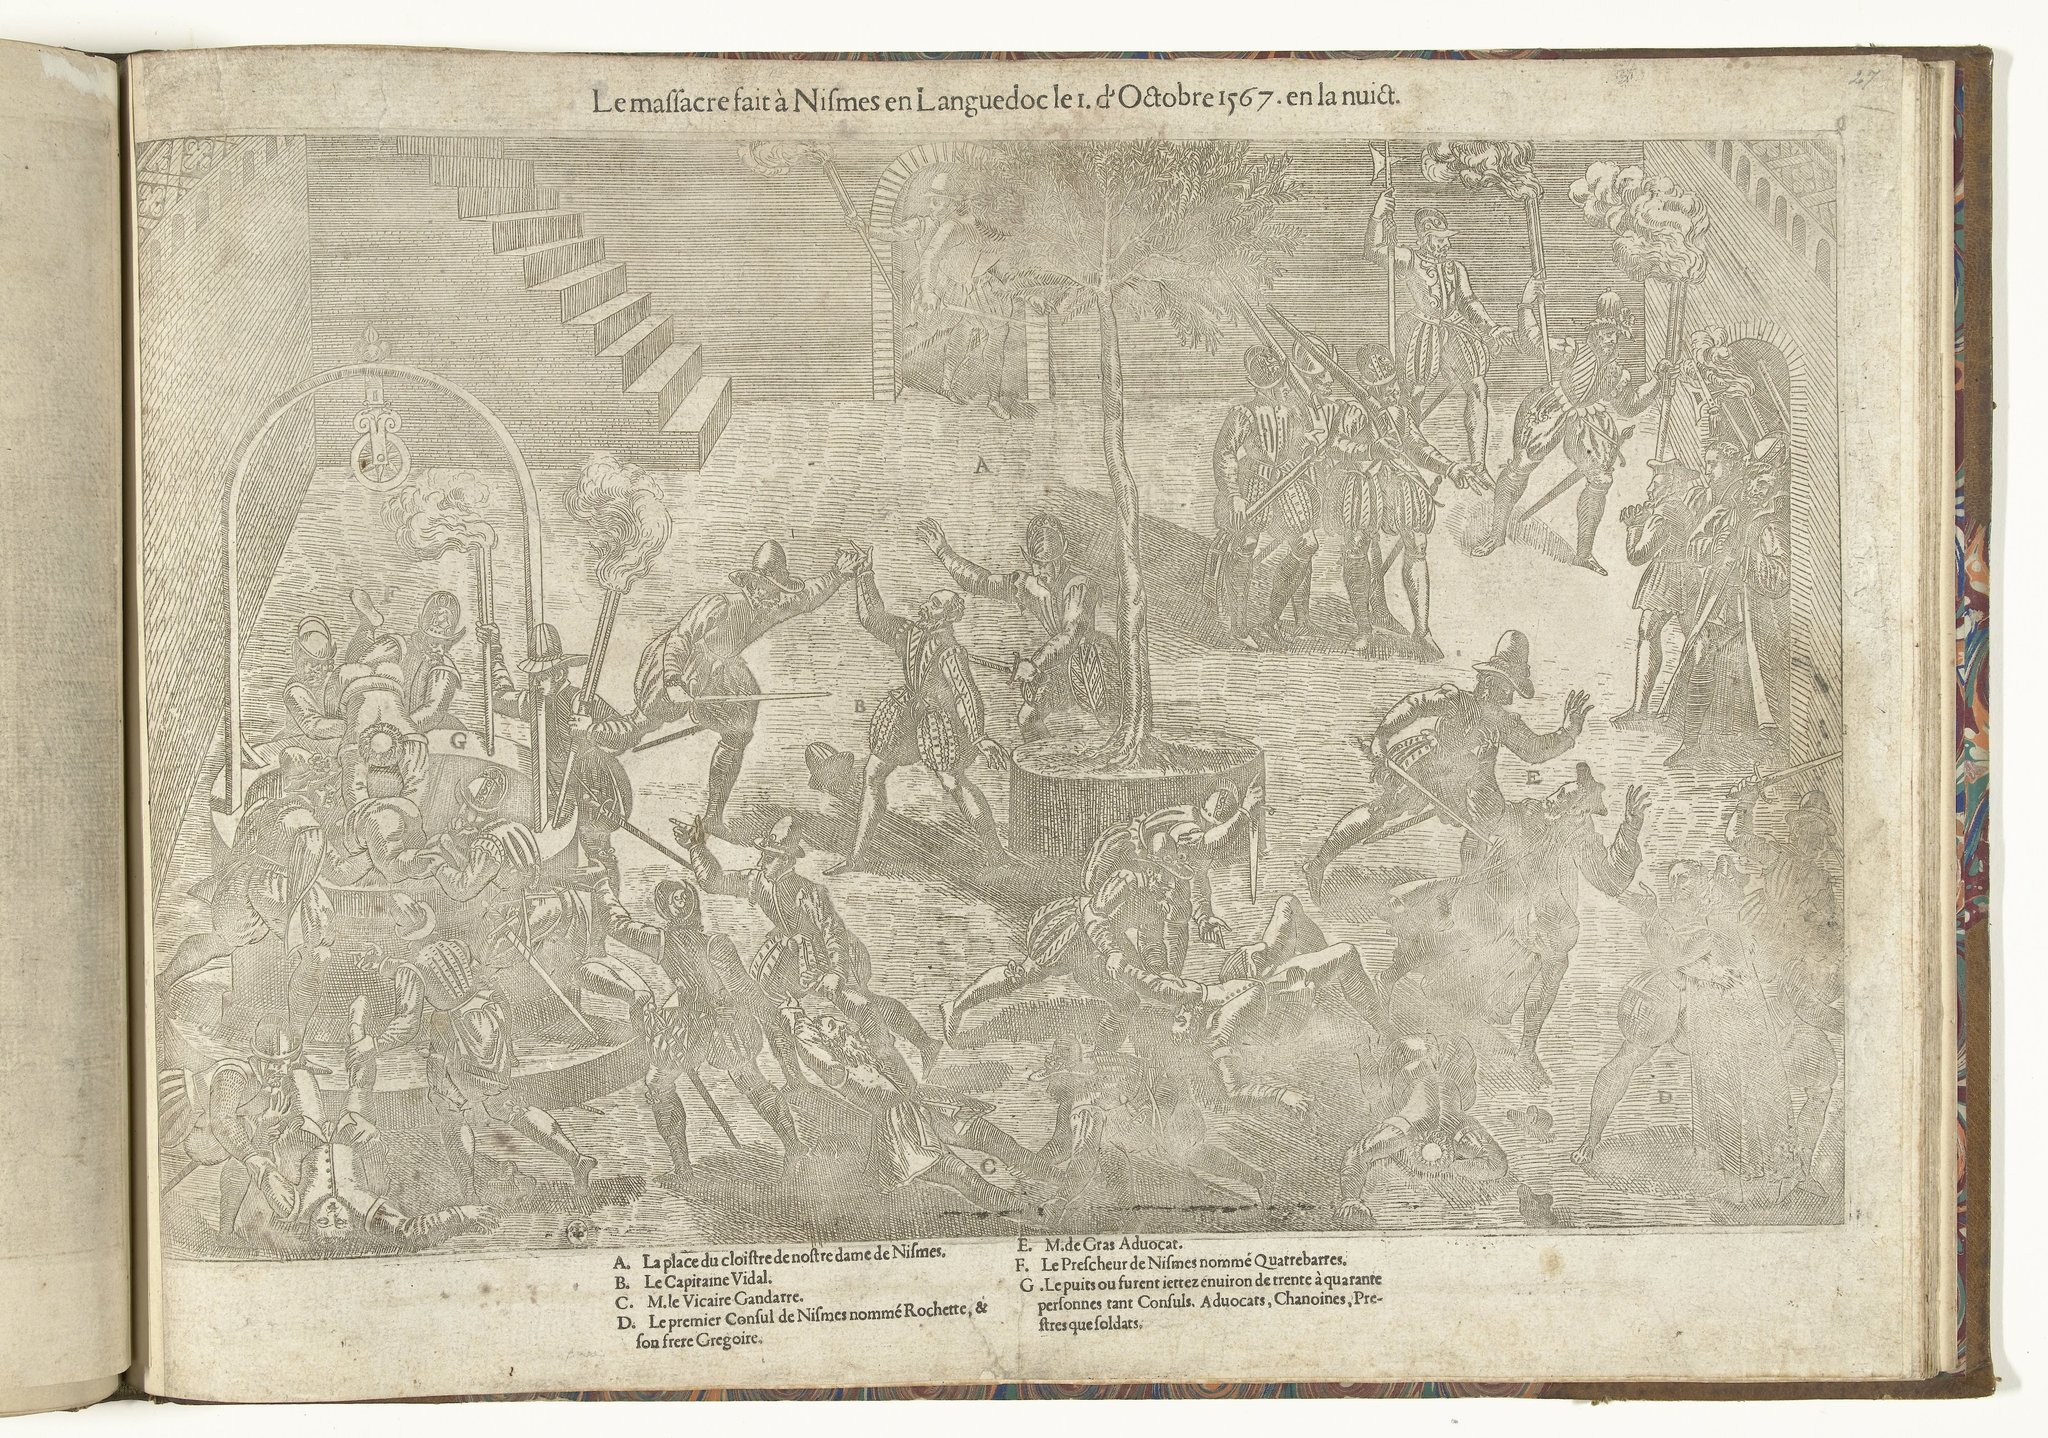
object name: history print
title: Overval op een klooster te Nîmes door de hugenoten, 1567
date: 1570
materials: paper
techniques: etching, letterpress printing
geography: france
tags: massacre ~ war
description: Overval te Nîmes door de hugenoten, 1 oktober 1567. Moordpartij op de binnenplaats van een klooster, lijken worden in de waterput gegooid. In het onderschrift de legenda A-G in het Frans. Ongenummerd.